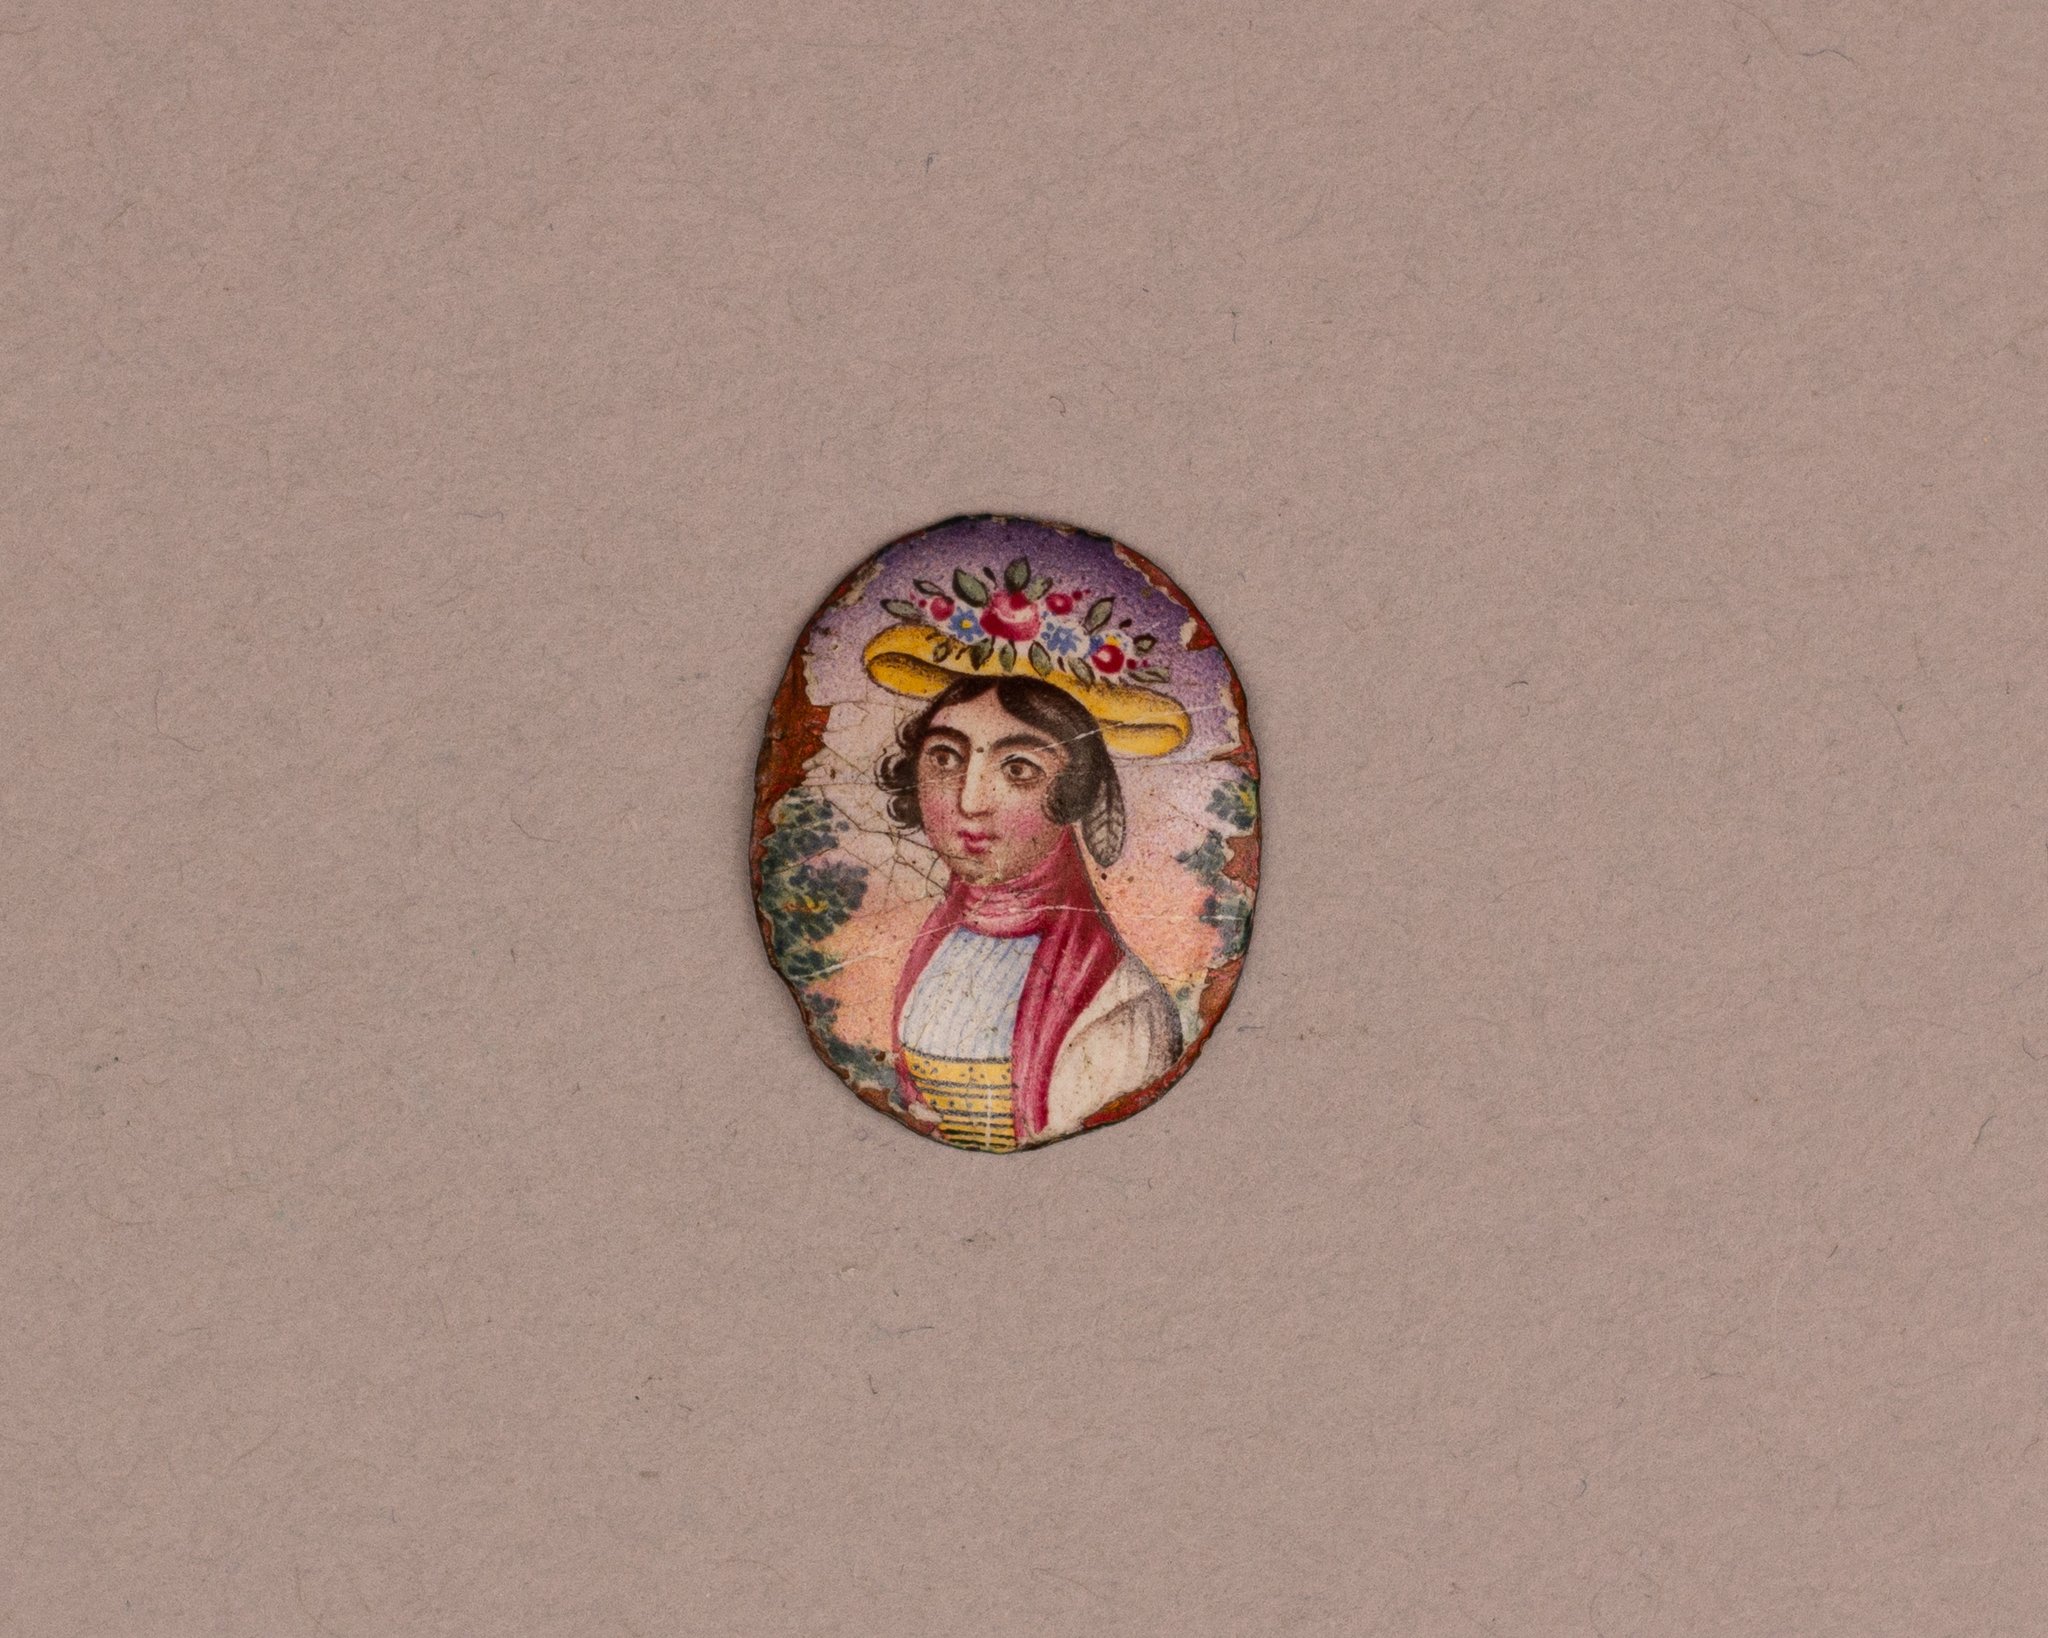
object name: disk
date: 1767-1800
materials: gold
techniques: enamel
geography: iran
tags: women